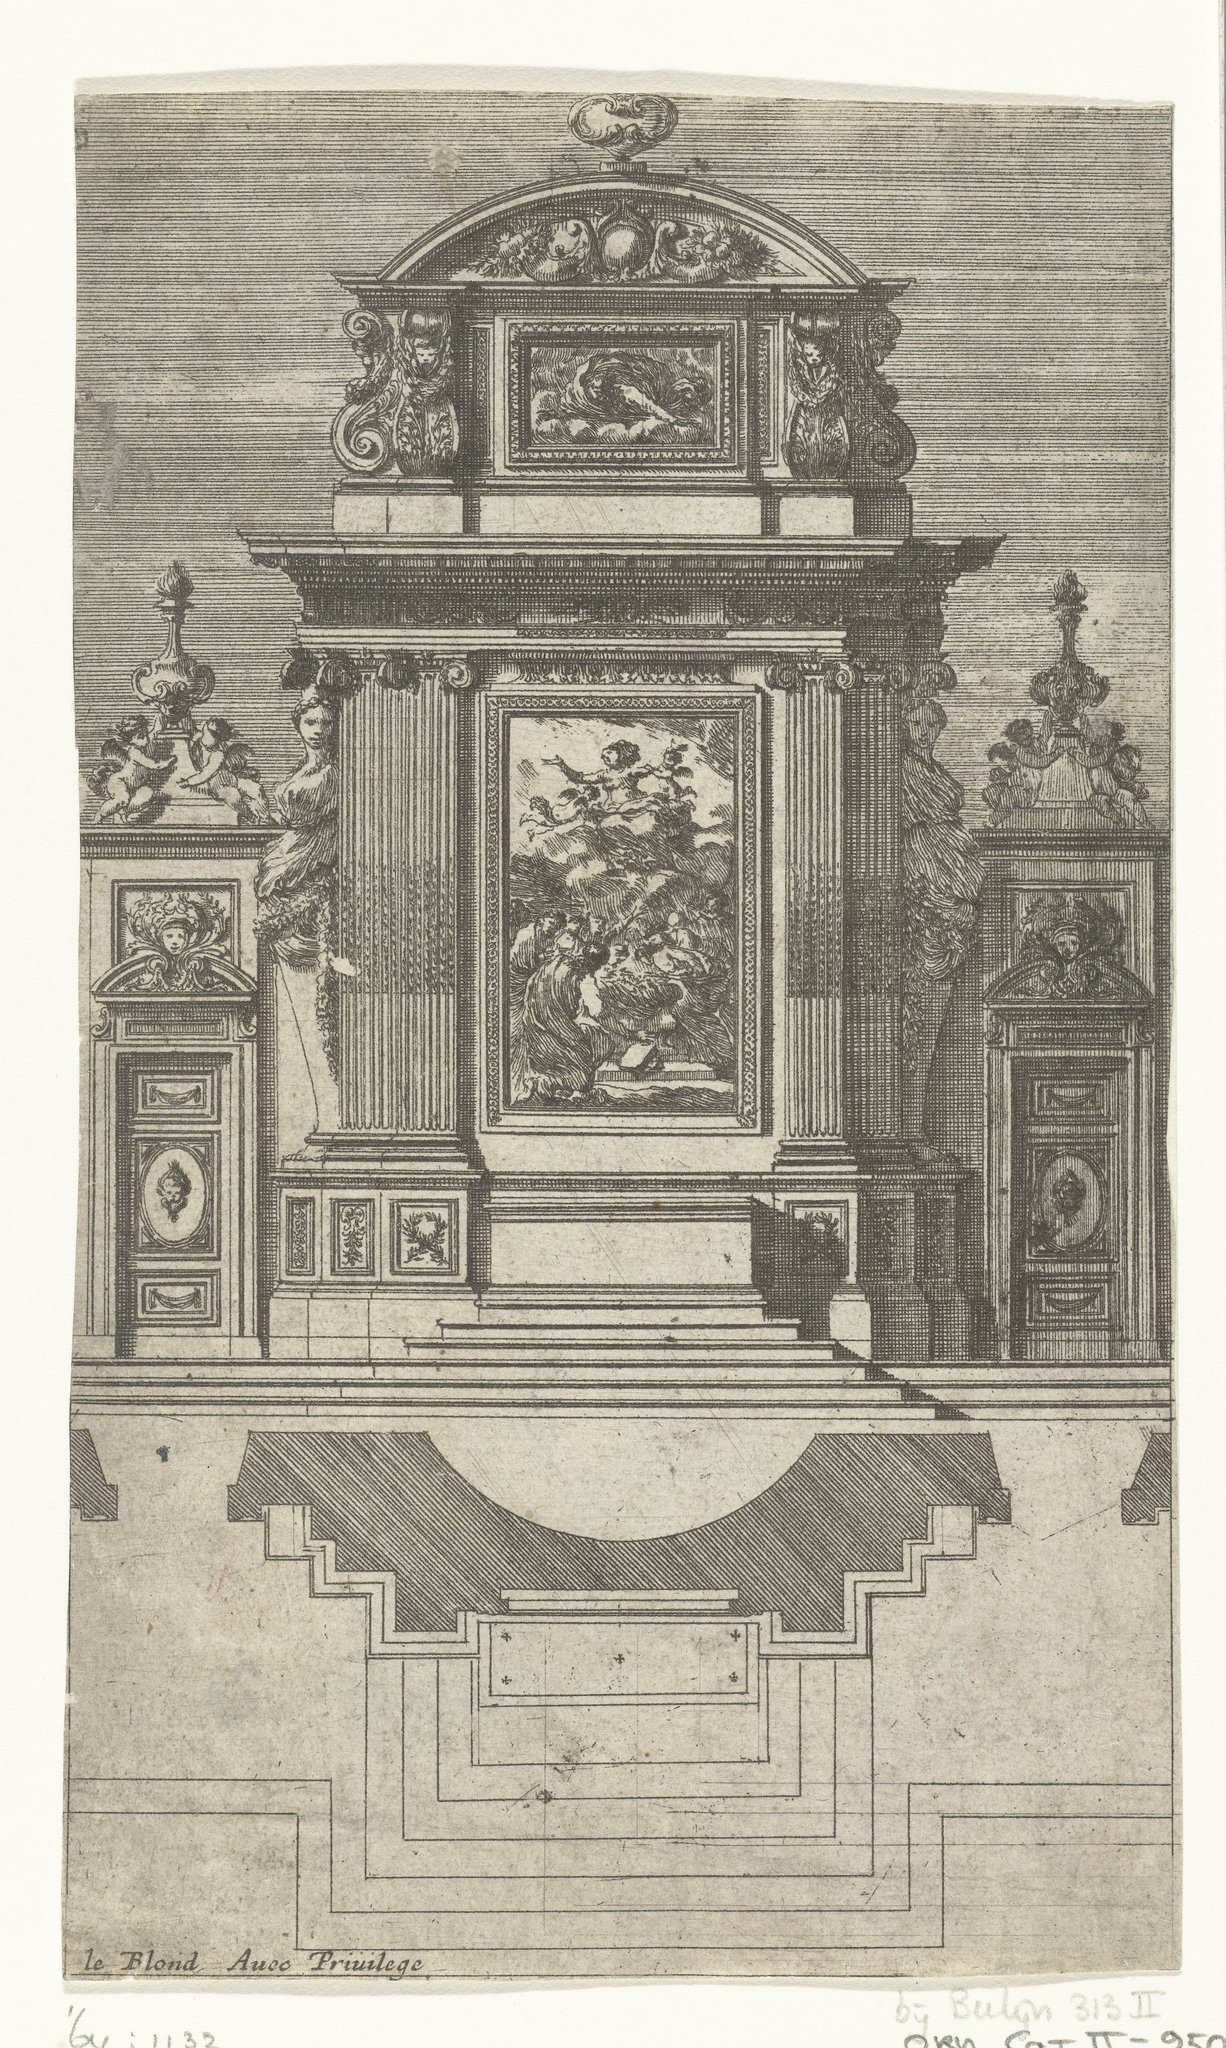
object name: print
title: Altaren met plan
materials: paper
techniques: etching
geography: france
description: Altaar geflankeerd door twee gekoppelde Ionische pilasters, op het schilderij staat de hemelvaart van de Maagd. Met opstand en plan. Uit serie van 6 bladen, eerste editie.